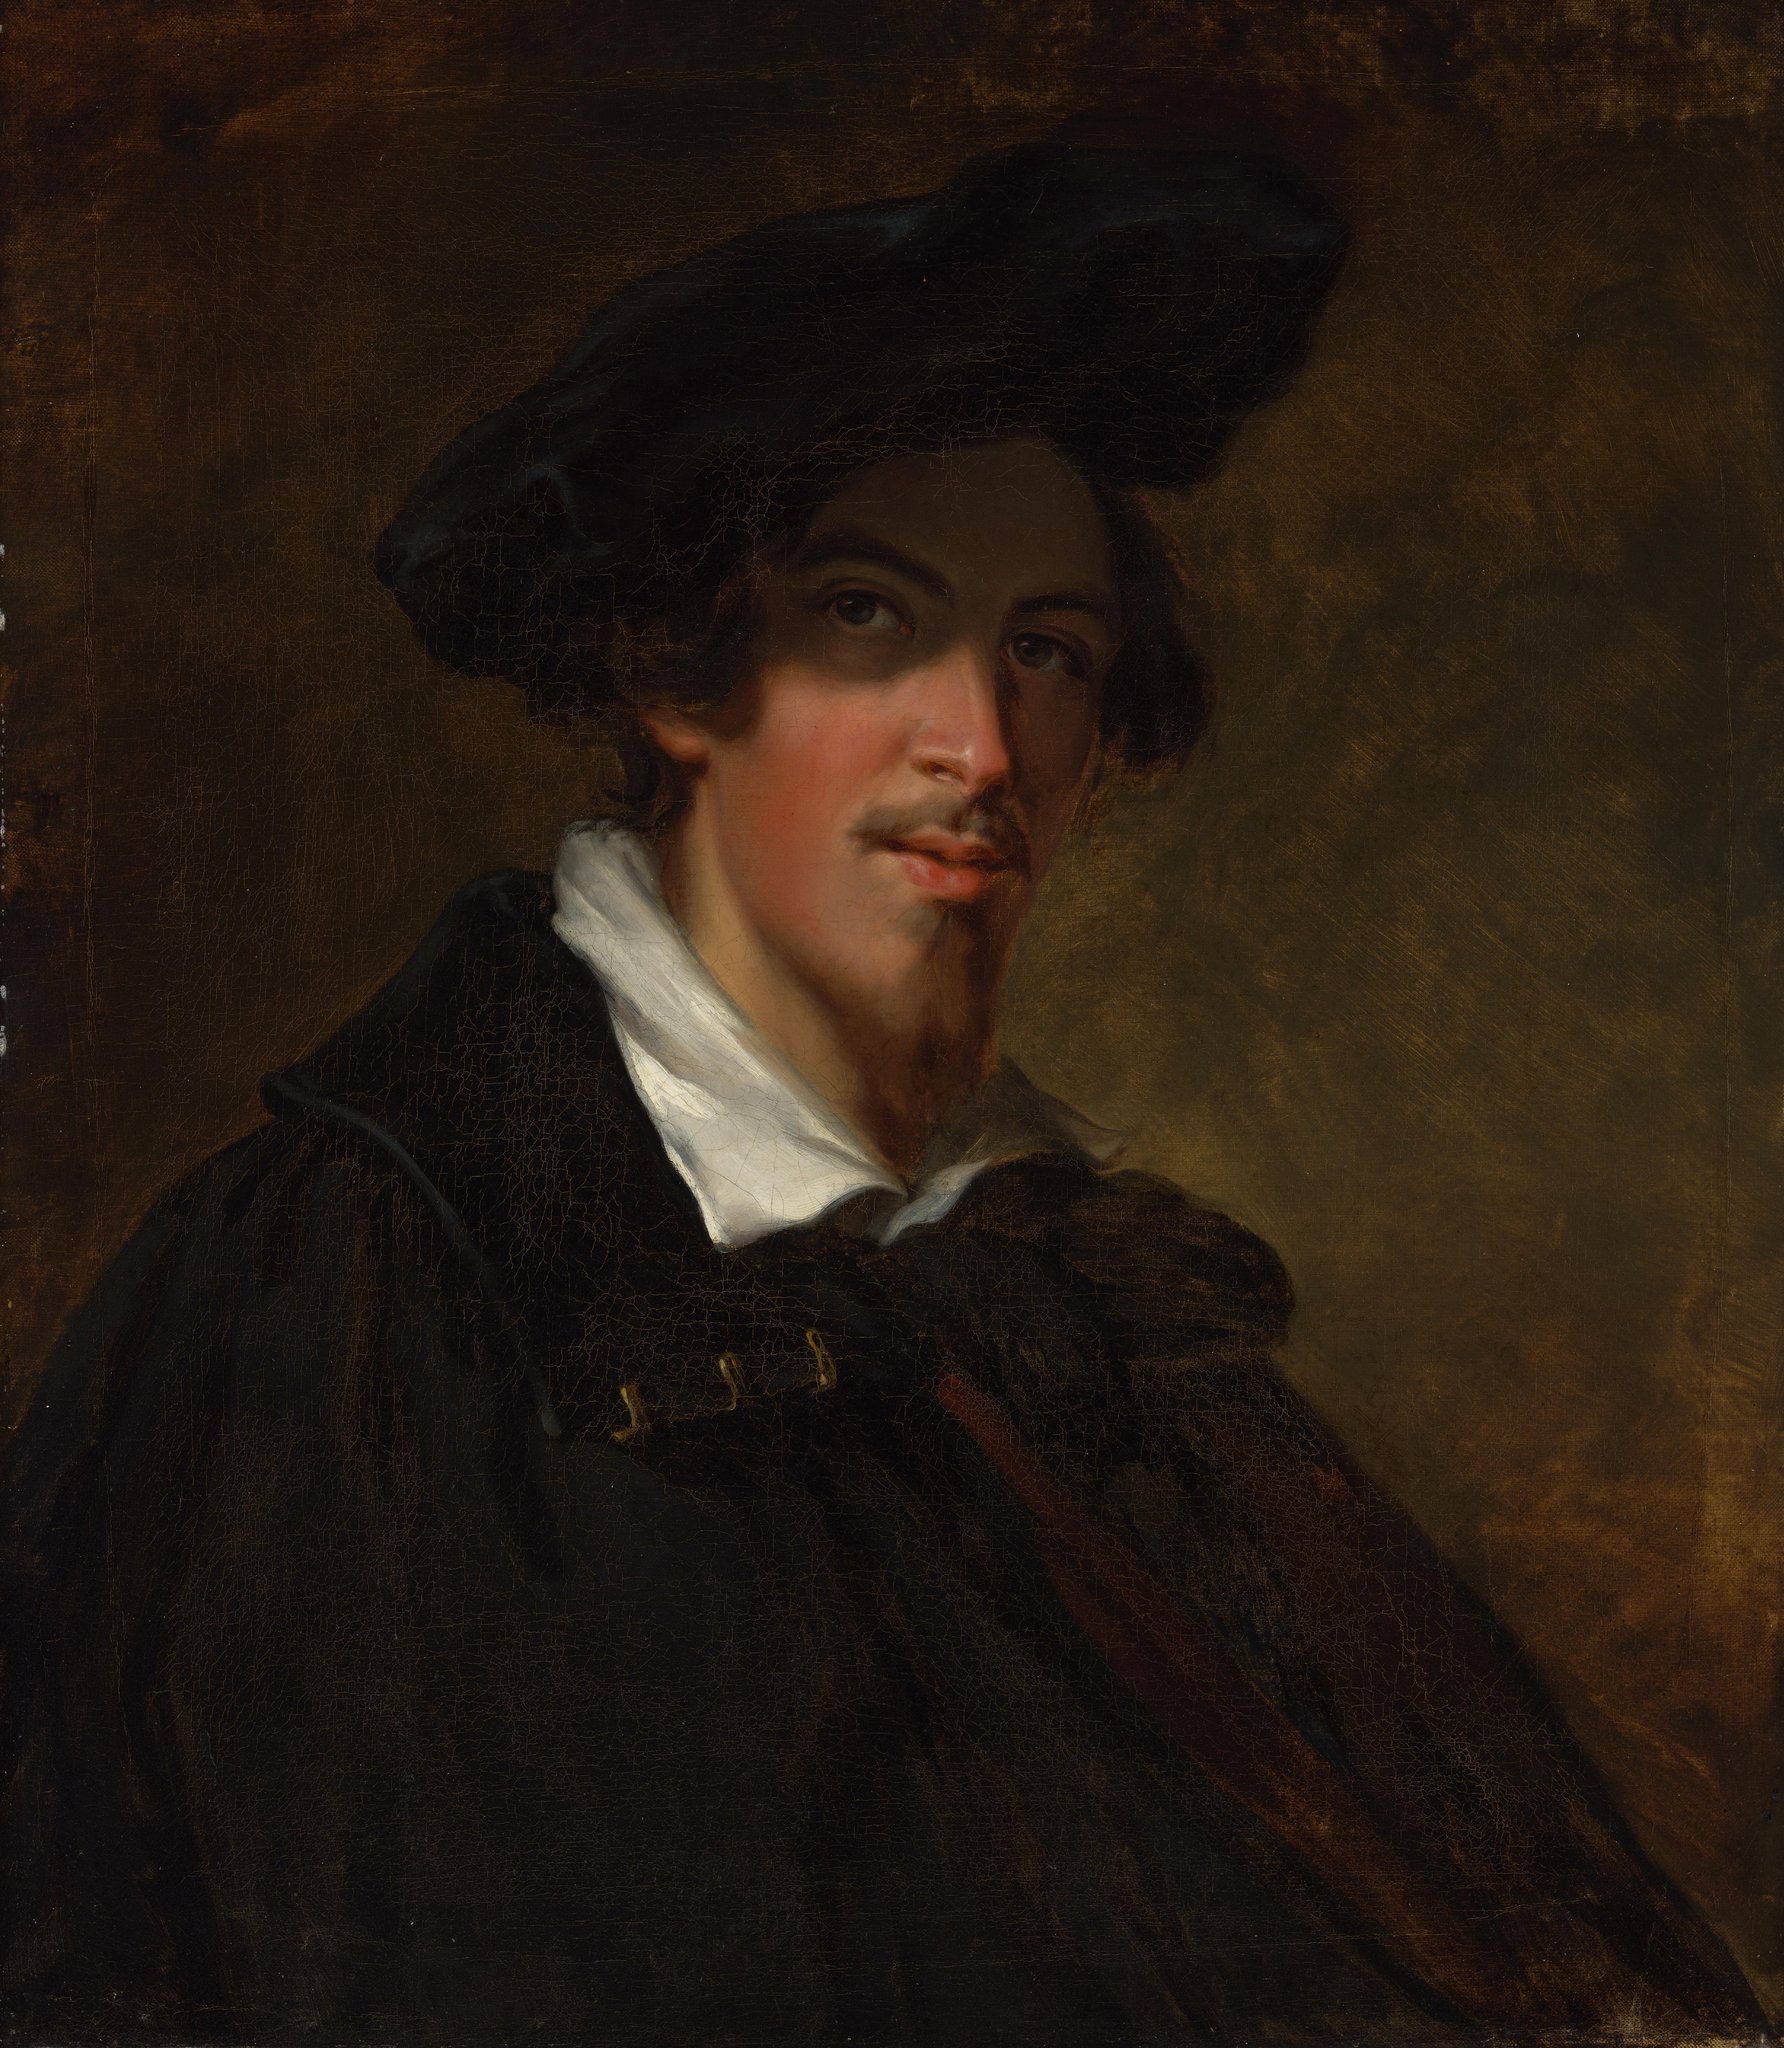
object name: painting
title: Portret van de kunstenaar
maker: pierre louis dubourcq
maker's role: draughtsman, painter, print maker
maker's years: 1815-1873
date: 1849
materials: canvas, oil, paint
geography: netherlands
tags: amsterdam, painter, draughtsman, pierre louis dubourcq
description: Zelfportret van de schilder gekleed in donkere mantel, witte kraag en zwarte baret, in driekwart profiel.